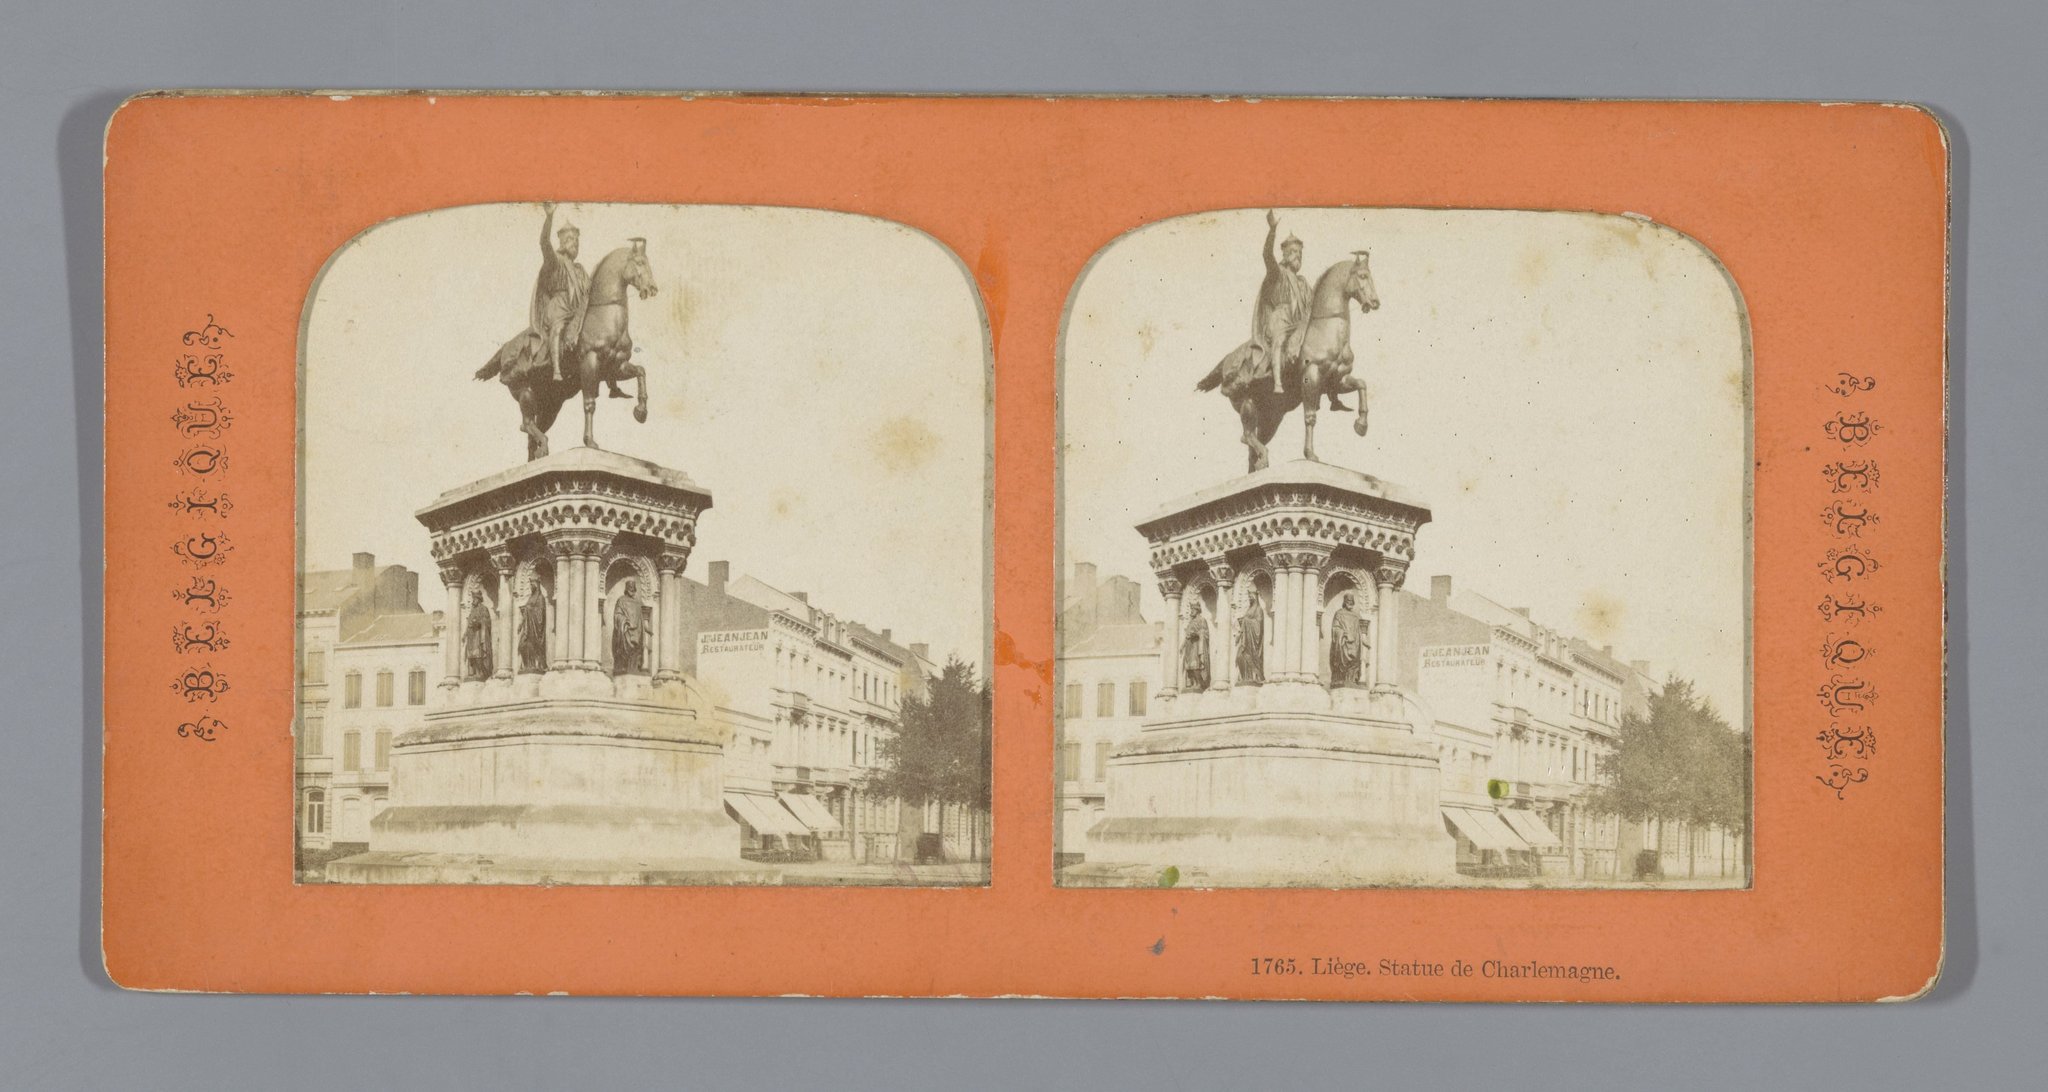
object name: tissue stereograph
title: Liège. Statue de Charlemagne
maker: Anonymous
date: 1855-1875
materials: cardboard, paper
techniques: albumen print, hand coloring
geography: liège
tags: charlemagne (holy roman emperor), equestrian statue, liège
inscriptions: inscription: ‘Augustus 1878 [...]’